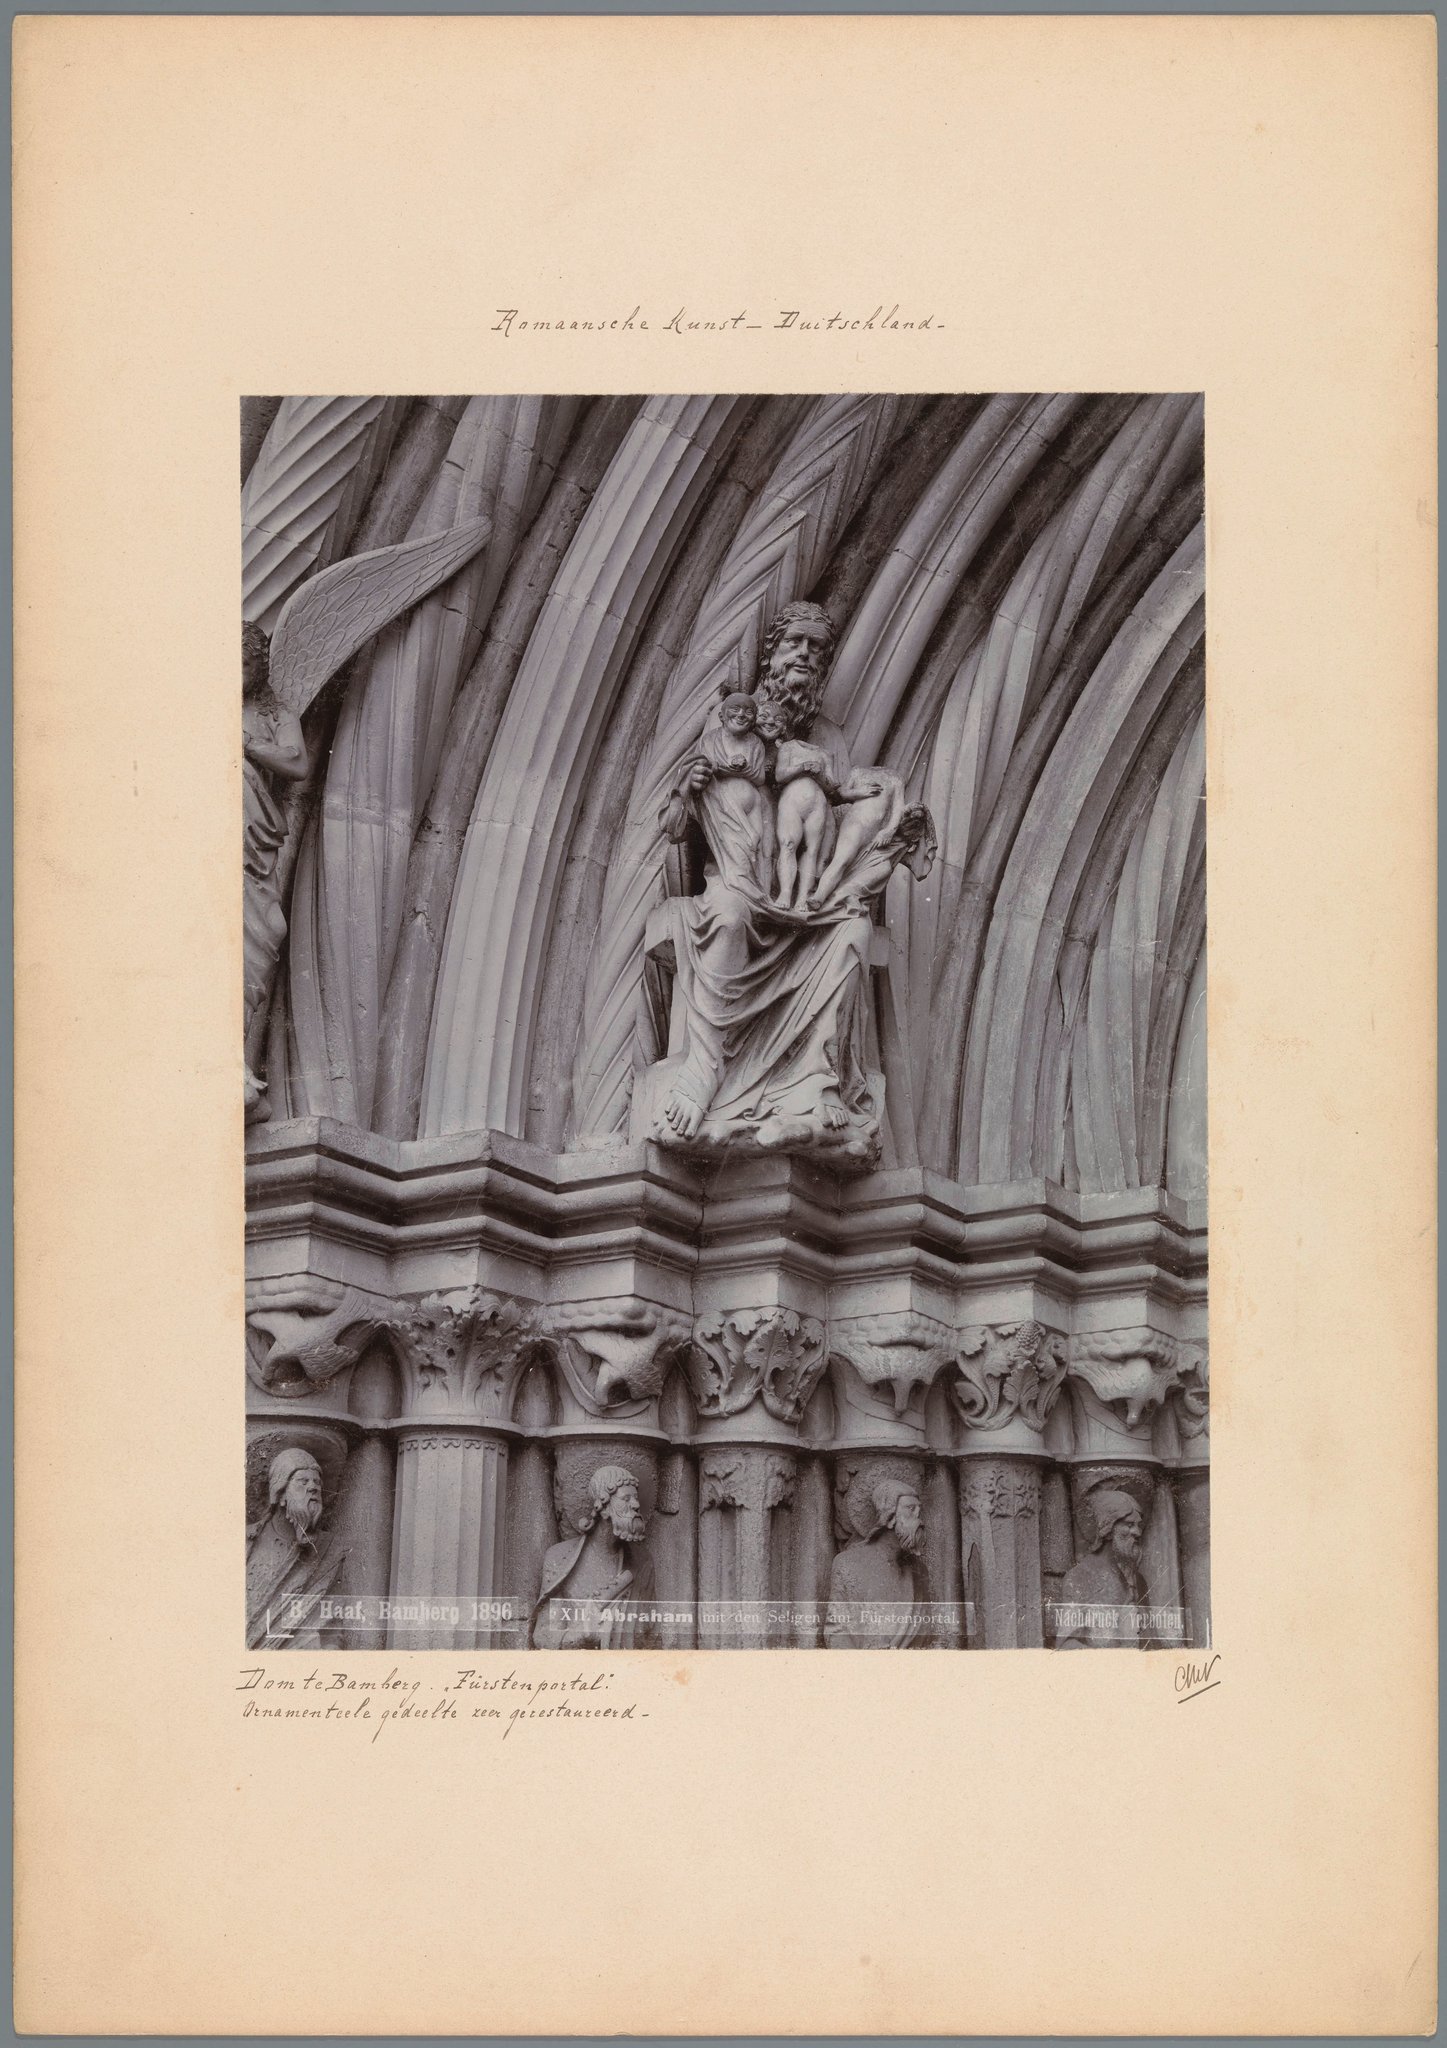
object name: photograph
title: Sculptuur aan het portaal van de Dom van Bamberg, voorstellende Abraham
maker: bernhard haaf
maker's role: fotograaf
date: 1896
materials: cardboard, photographic support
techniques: daylight paper print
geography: bamberg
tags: church (exterior), story of abraham, sculpture, façade (of house or building)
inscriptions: collector's mark: ‘INSTITUUT VOOR KUNST- NIJVERHEIDSONDERWIJS GABRIËL METSUSTRAAT No. 16. AMSTERDAM’, collector's mark: ‘KUNSTNIJVERHEIDSCHOOL QUELLINUS AMSTERDAM FRANS HALSSTRAAT 14.’, number: ‘XII.’, inscription: ‘CWN.’, inscription: ‘Romaansche Kunst - Duitschland. Dom te Bamberg . ,,Fürstenportal.'' Ornamenteele gedeelte zeer gerestaureerd.’